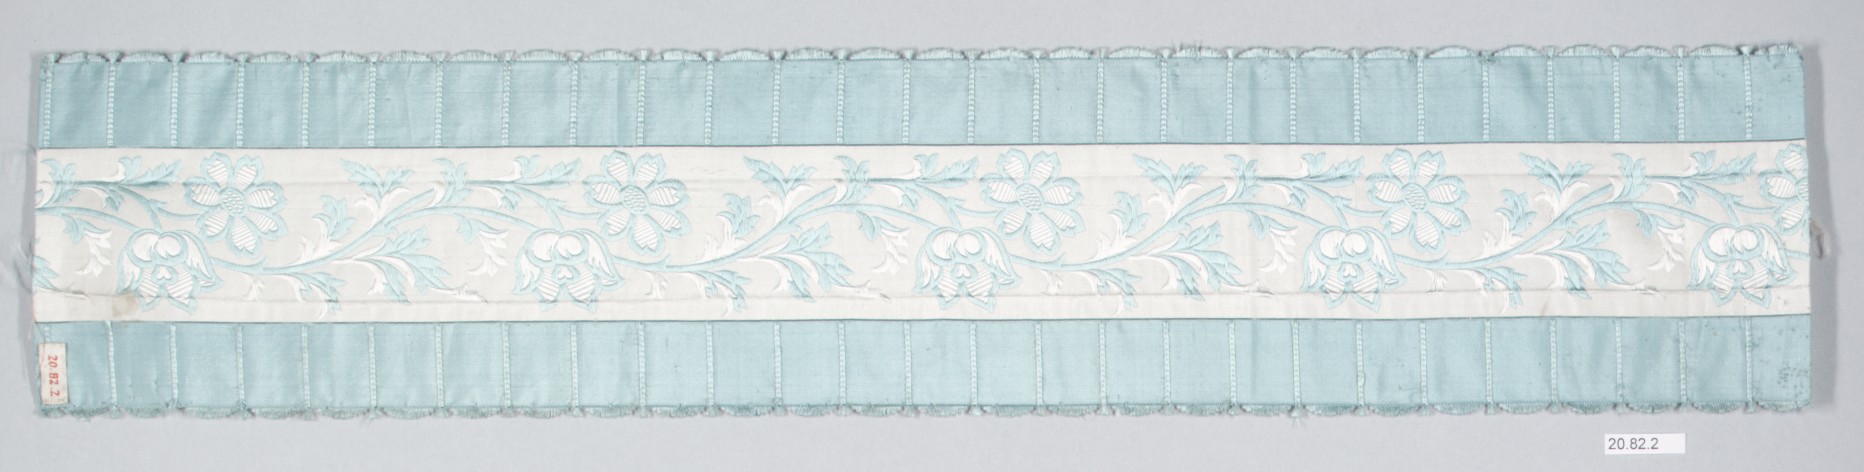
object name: ribbon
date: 1801-1833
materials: silk